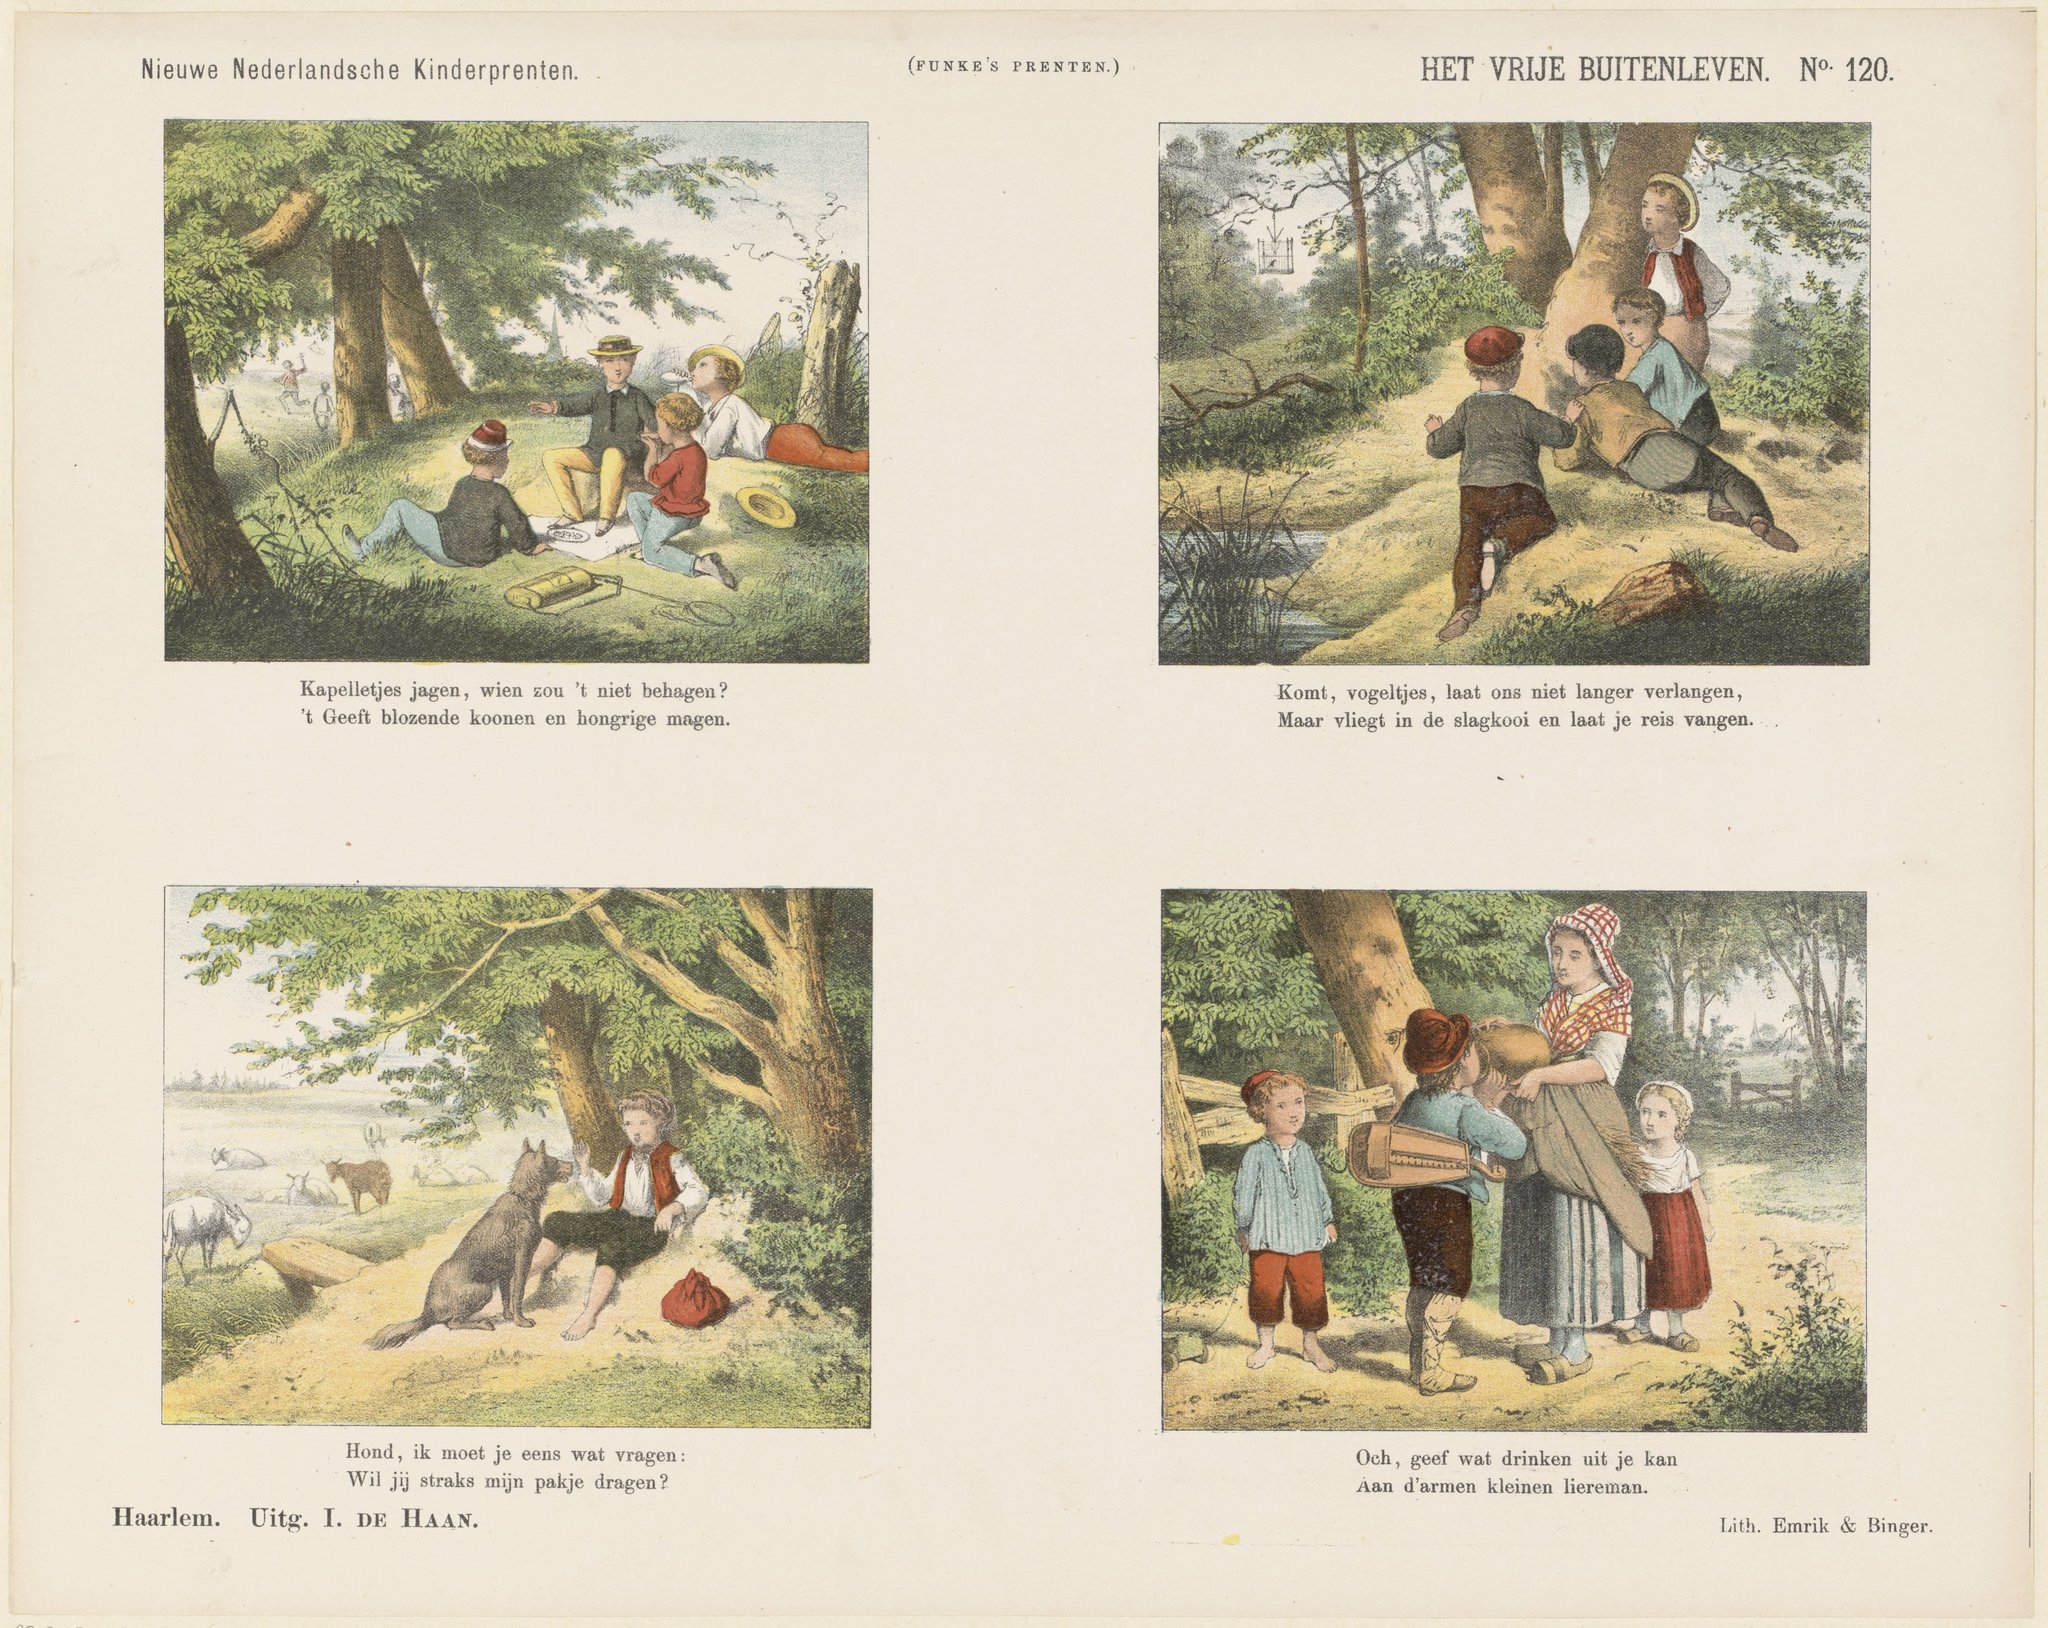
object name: print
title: Het vrije buitenleven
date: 1875-1903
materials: paper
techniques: lithograph, letterpress printing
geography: haarlem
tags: herding, herdsman, herdswoman, shepherd, shepherdess, cowherd, etc., hunting butterflies, children's games and plays (+ out of doors (sports, games, etc.)), child and nature (games and plays)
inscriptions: collector's mark: Lugt 2760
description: Blad met 4 voorstellingen van kinderen in de natuur. Onder elke voorstelling een tweeregelig vers. Genummerd rechtsboven: No. 120.